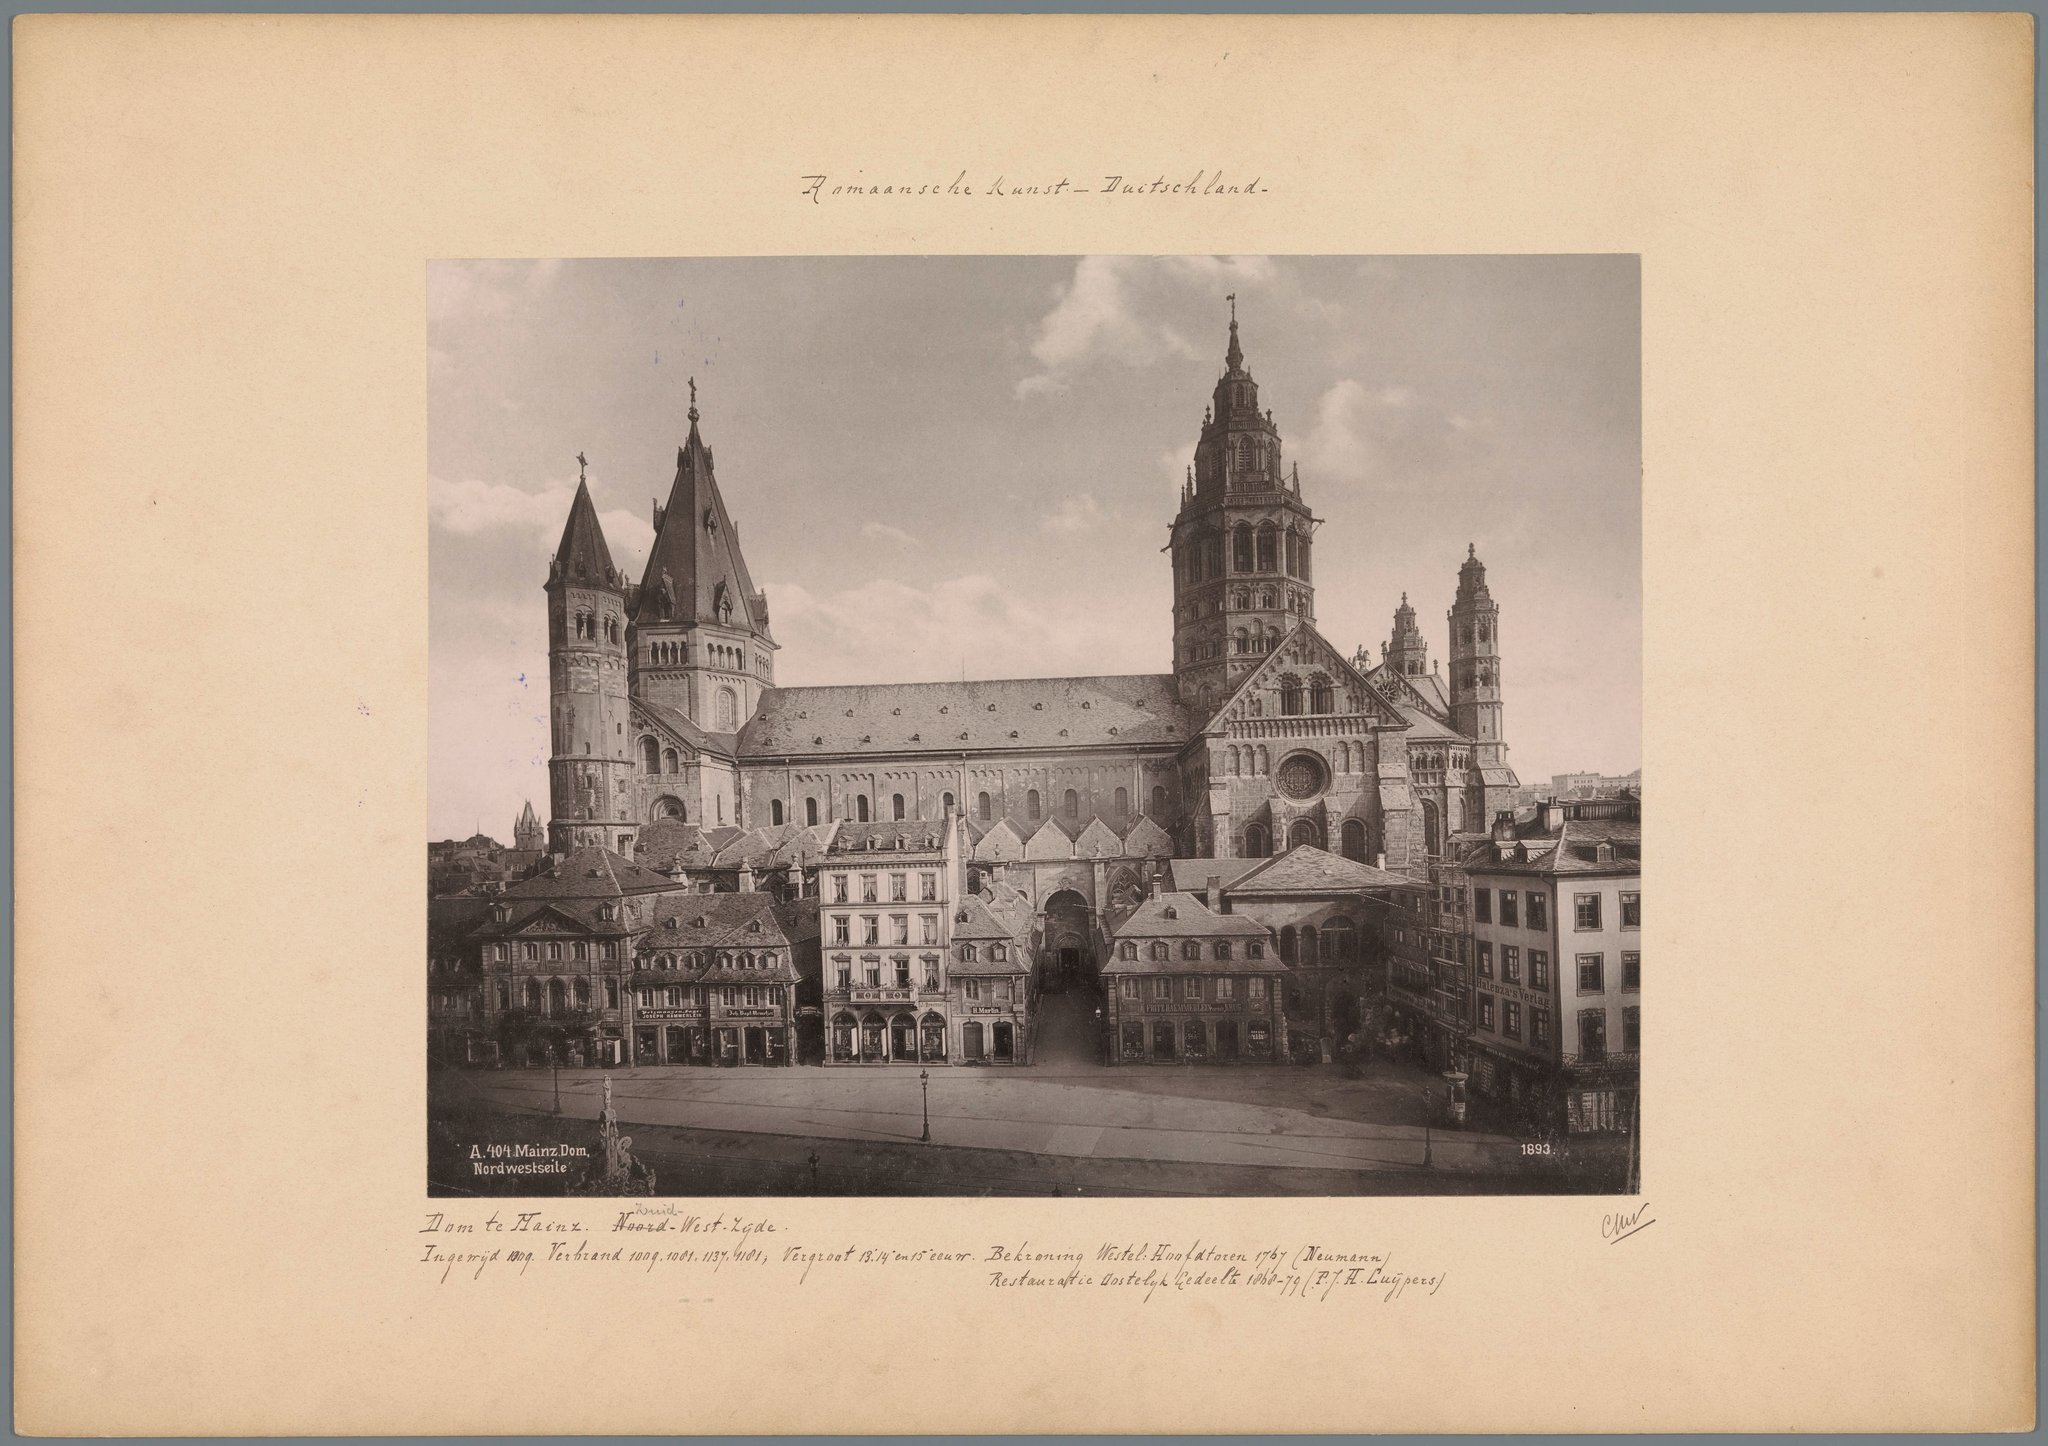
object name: photograph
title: Gezicht op de Dom van Mainz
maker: Anonymous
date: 1893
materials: cardboard, paper, ink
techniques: photograph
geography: mainz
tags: church (exterior), façade (of house or building), parts of church exterior and annexes: tower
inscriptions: collector's mark: ‘KUNSTNIJVERHEIDSCHOOL QUELLINUS AMSTERDAM FRANS HALSSTRAAT 14.’, name: ‘PAUL ROBERT PARIS’, collector's mark: ‘INSTITUUT VOOR KUNST- NIJVERHEIDSONDERWIJS GABRIËL METSUSTRAAT No. 16. AMSTERDAM’, inscription: ‘Romaansche Kunst - Duitschland. Dom te Mainz (...) Restauratie Oostelijk Gedeelte 1868-79 (P.J.H. Cuijpers.)’, inscription: ‘CWN.’